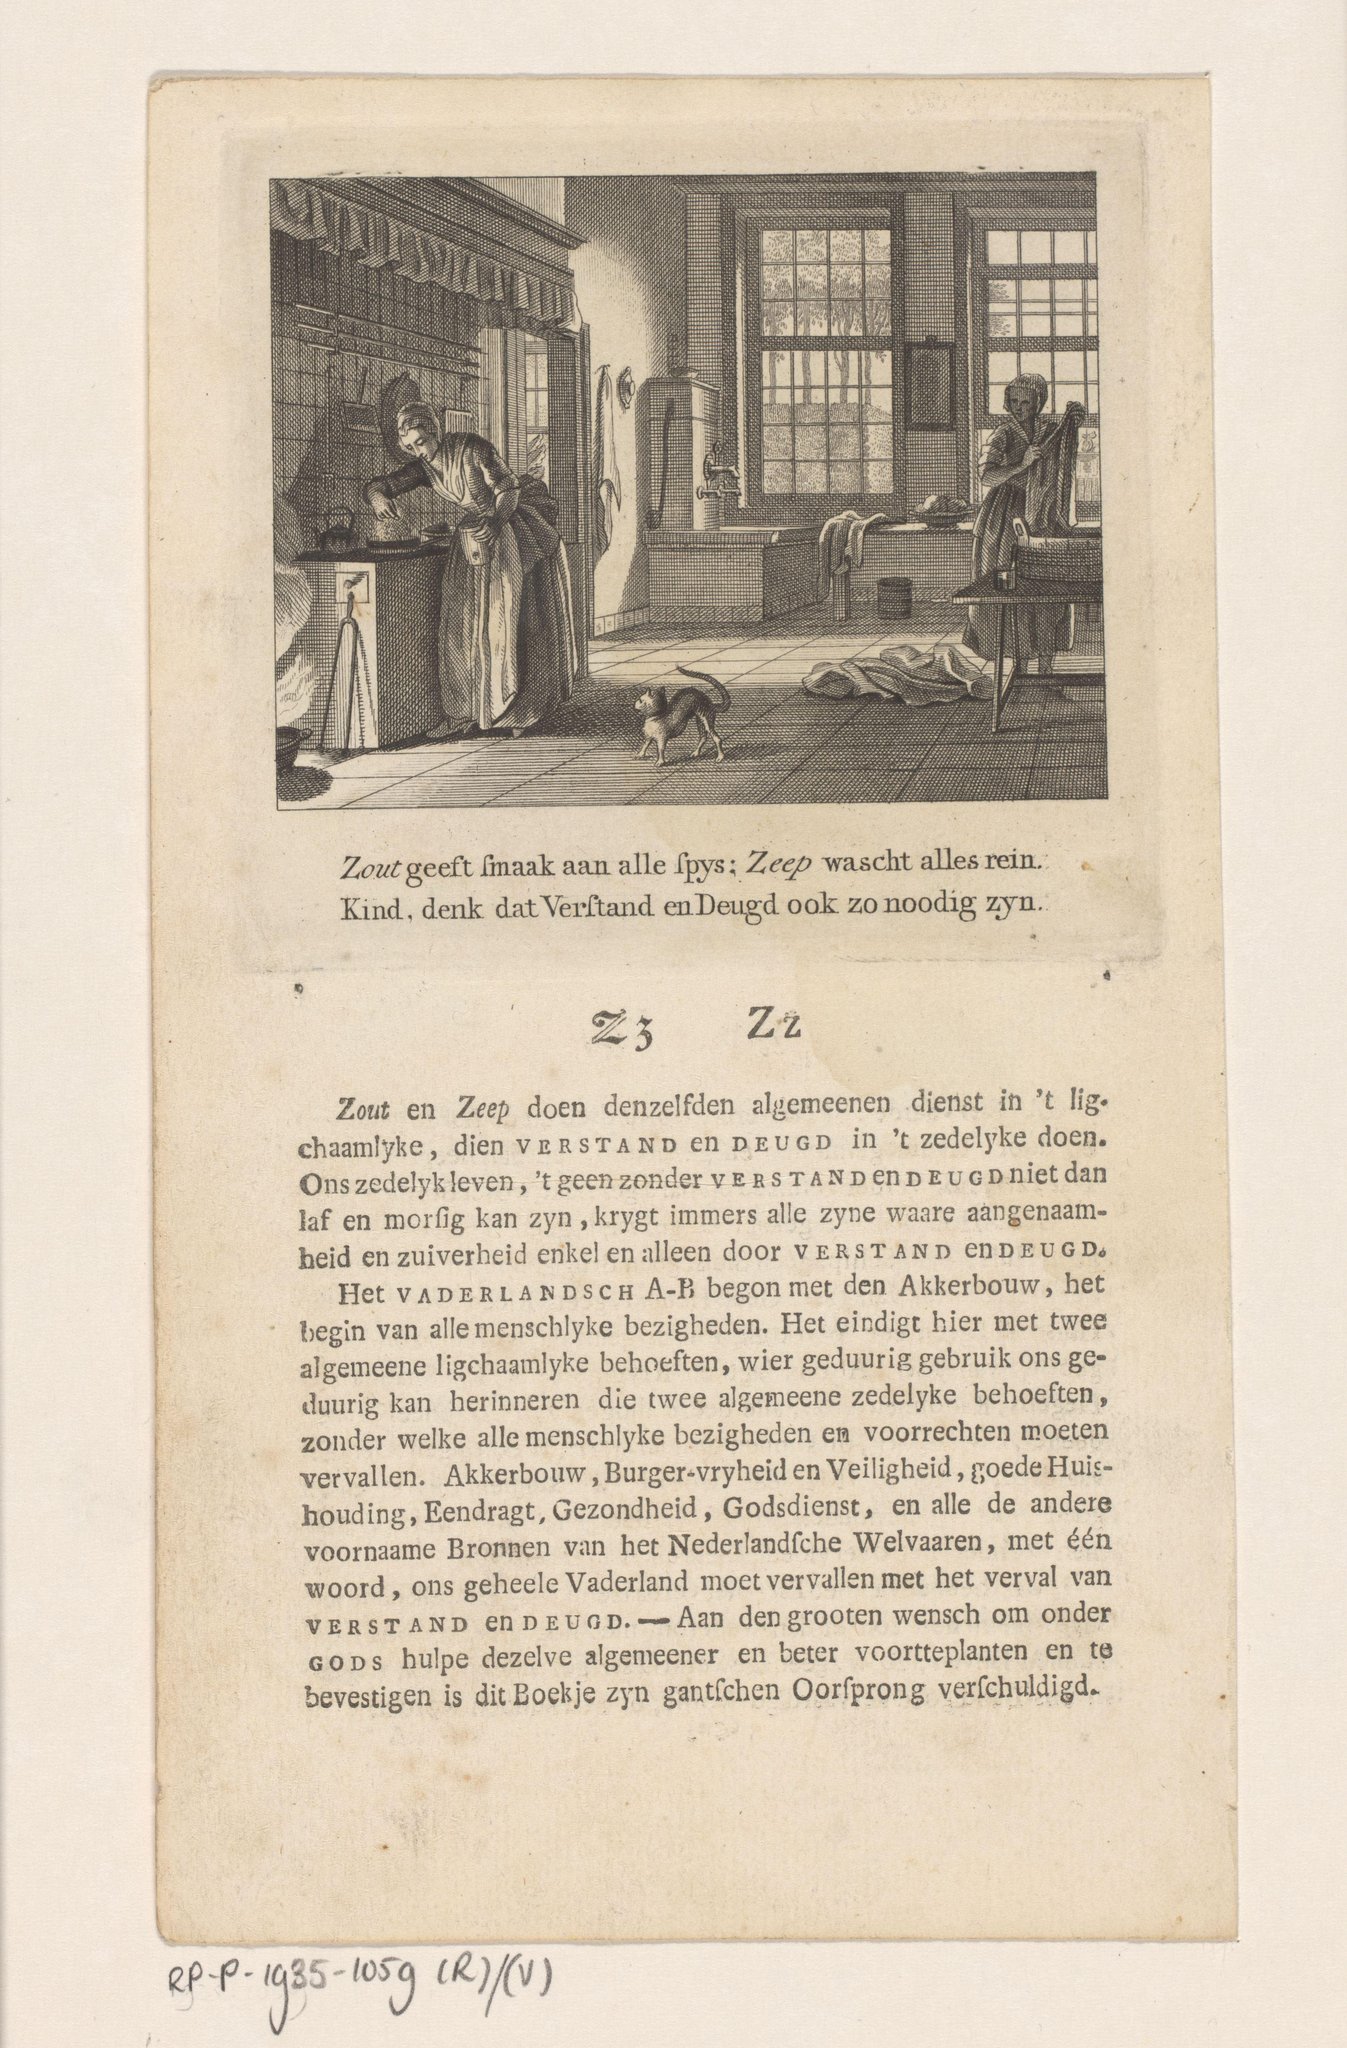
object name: book illustration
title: Zout en zeep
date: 1781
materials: paper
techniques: etching, letterpress printing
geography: amsterdam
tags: cat, kitchen-interior, laundering, cooking food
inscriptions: collector's mark: Lugt 2760, collector's mark: Lugt 2228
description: In een keuken staat een vrouw bij het aanrecht en strooit zout in het eten. Rechts doet een vrouw de was in een tobbe. Midden op de vloer een kat. Onderaan een verklarende tekst bij de letter Z.